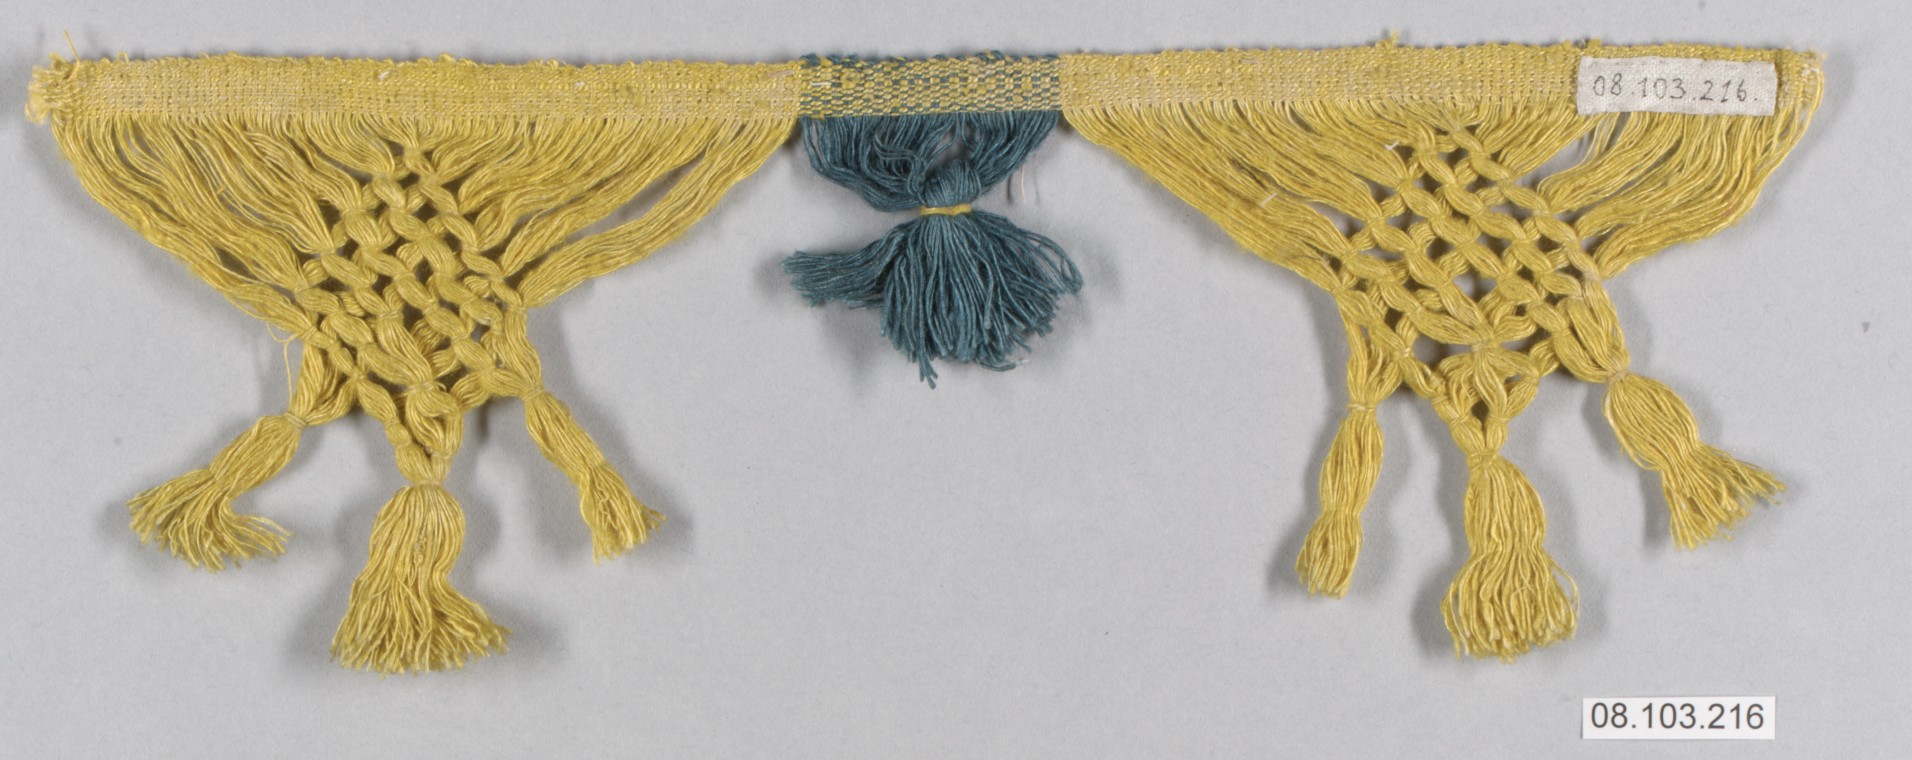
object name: fringe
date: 1701-1800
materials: cotton